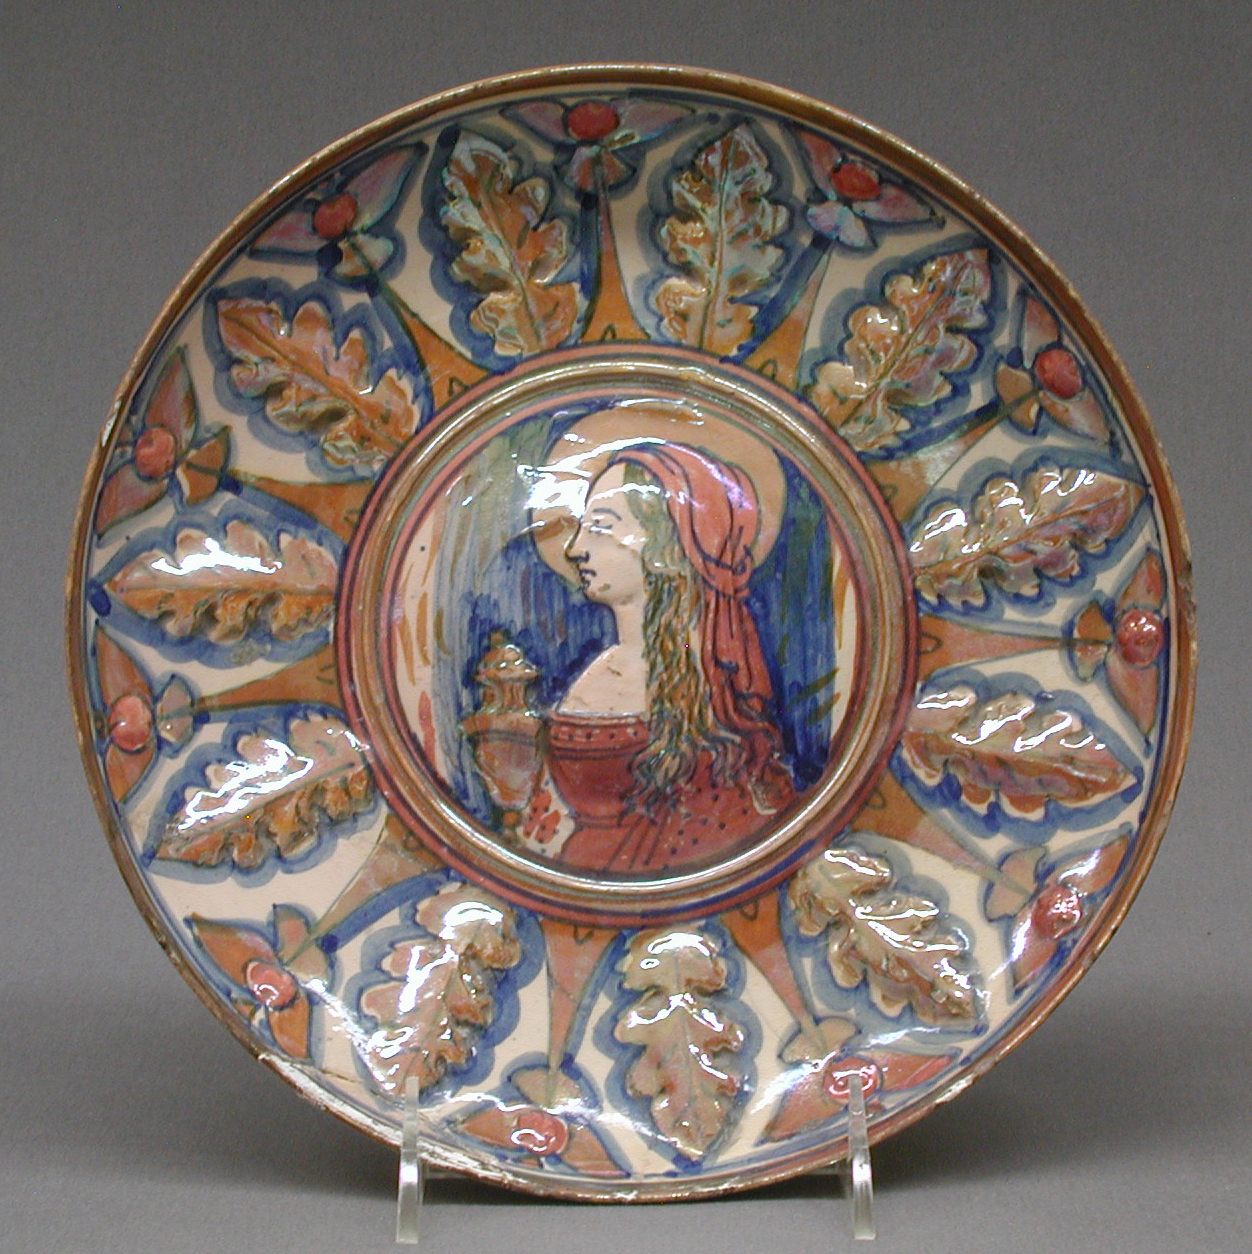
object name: tazza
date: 1530-1540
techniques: maiolica, glazing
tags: profiles,women